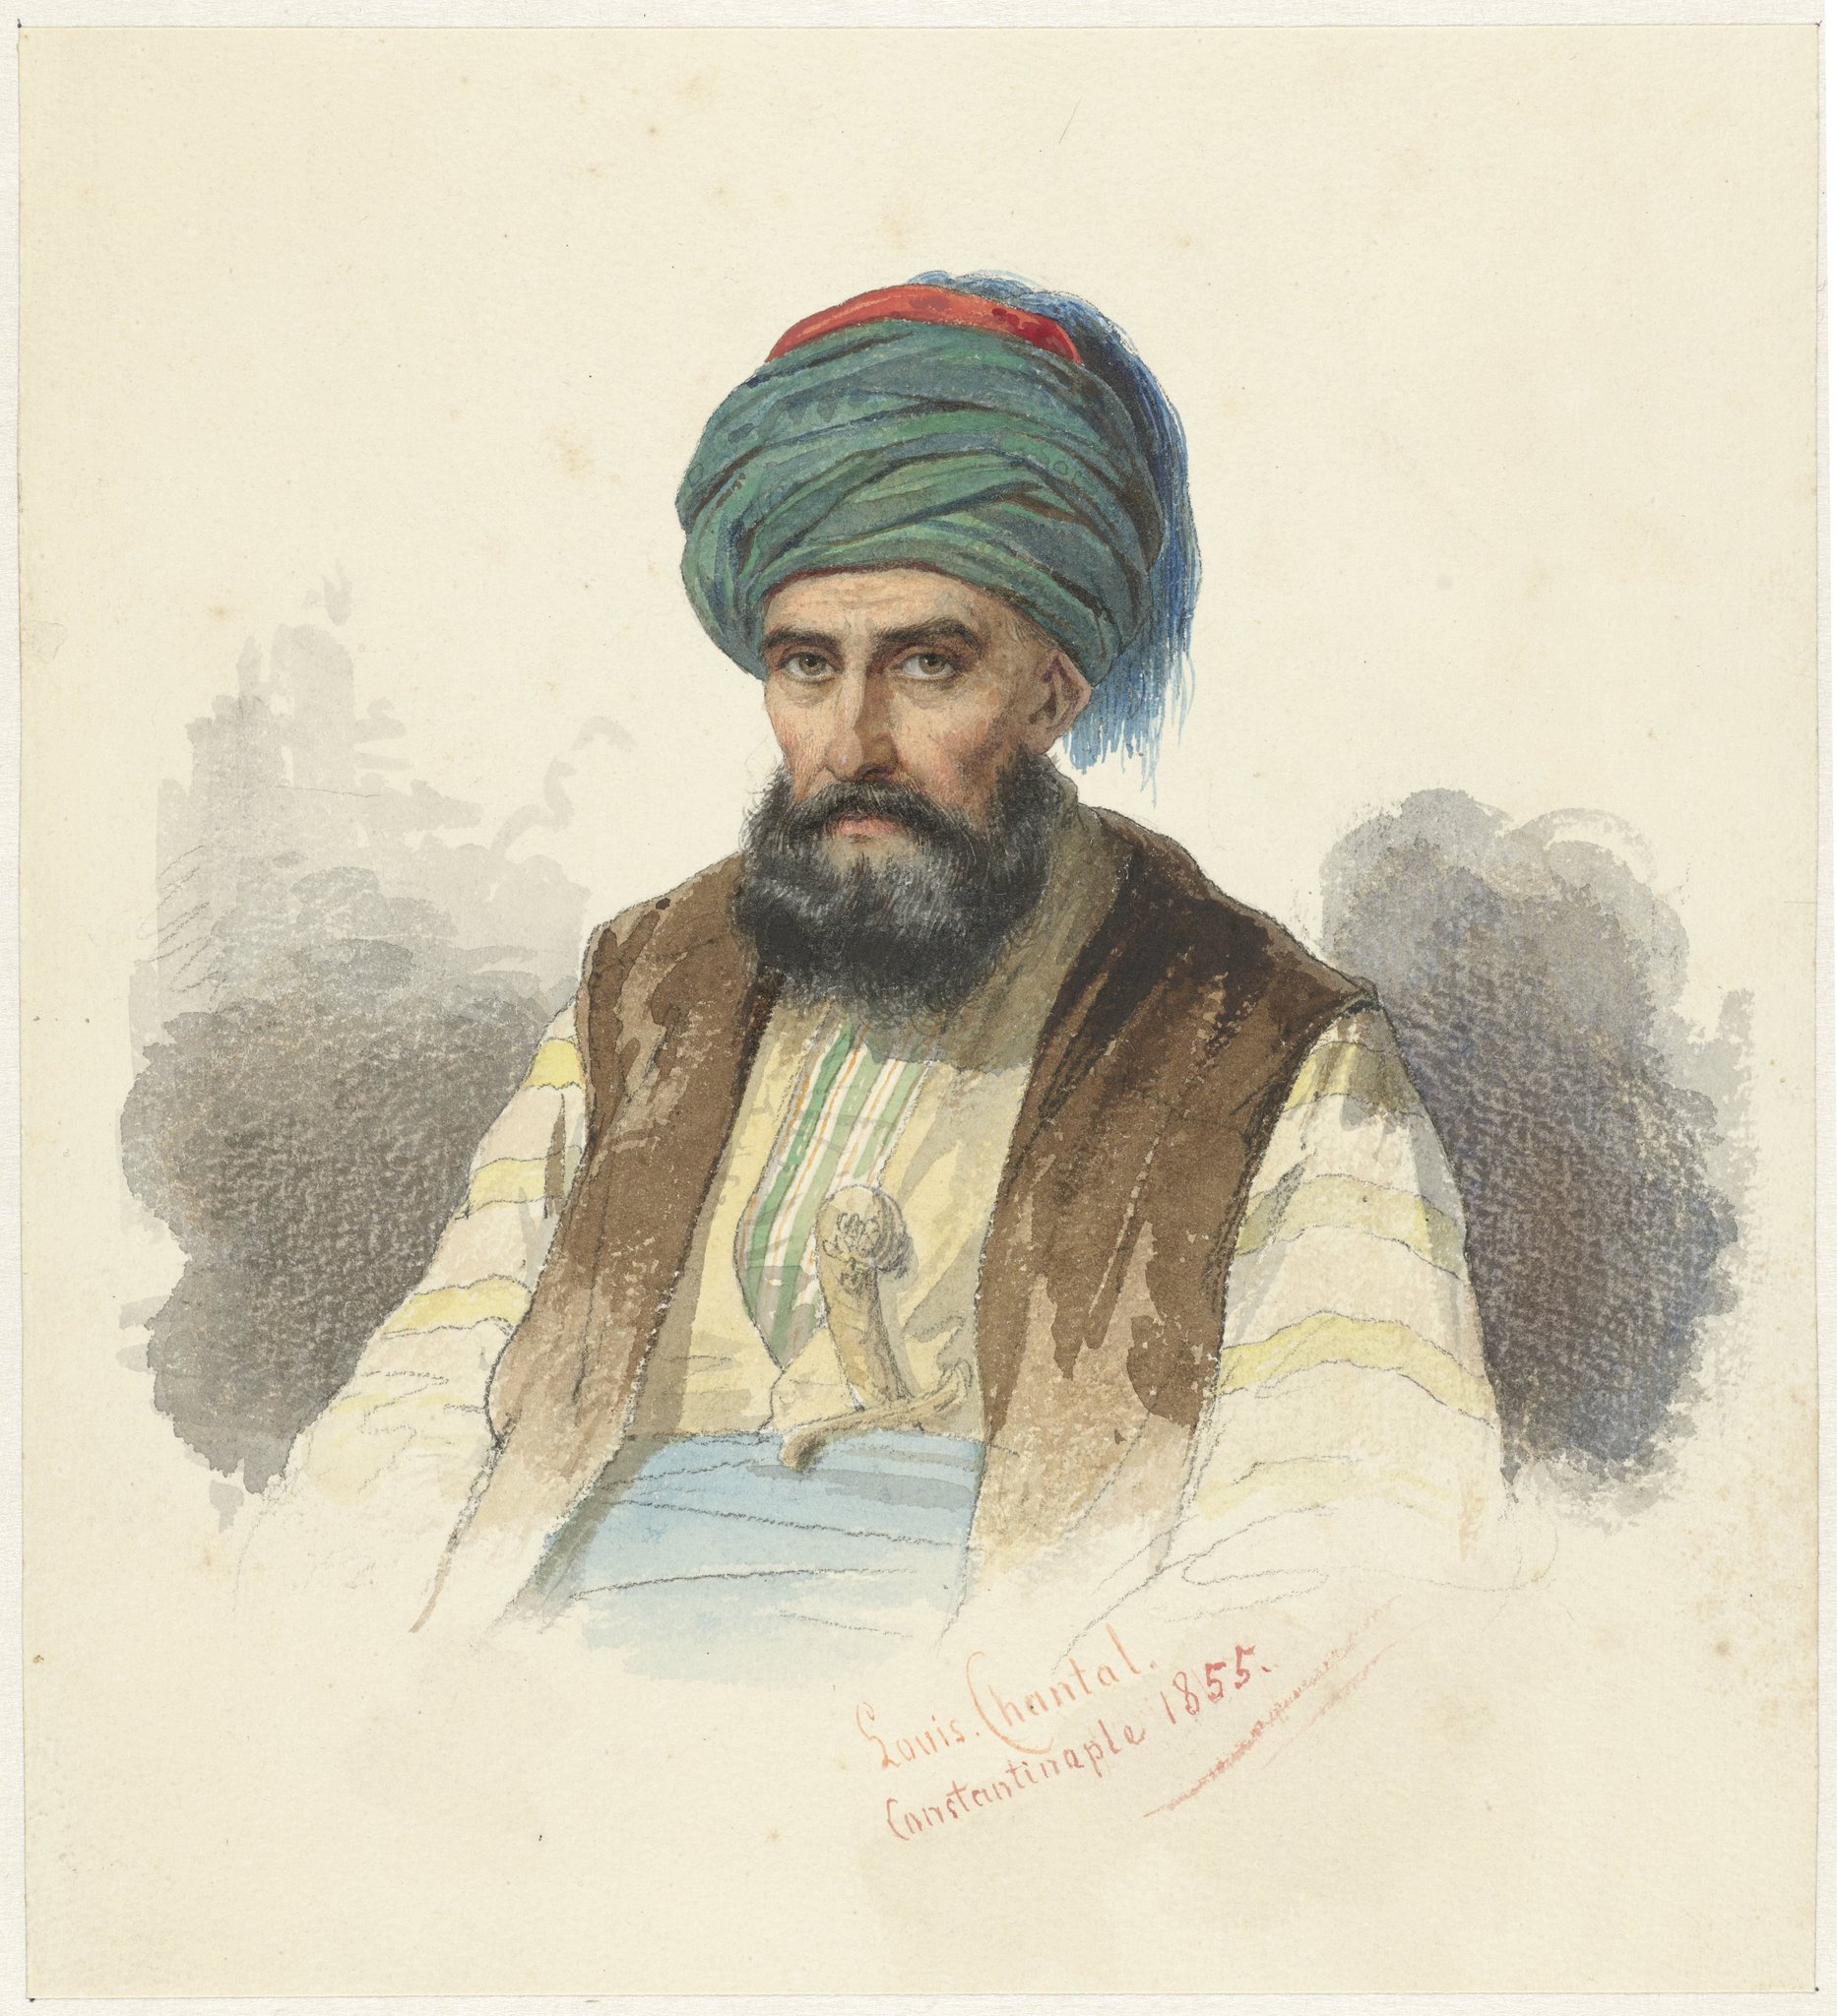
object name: drawing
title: Zittende Turk met een dolk in zijn ceintuur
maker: louis chantal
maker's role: draughtsman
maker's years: 1822-1899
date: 1855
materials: chalk, paper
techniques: brush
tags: asiatic races and peoples: turks